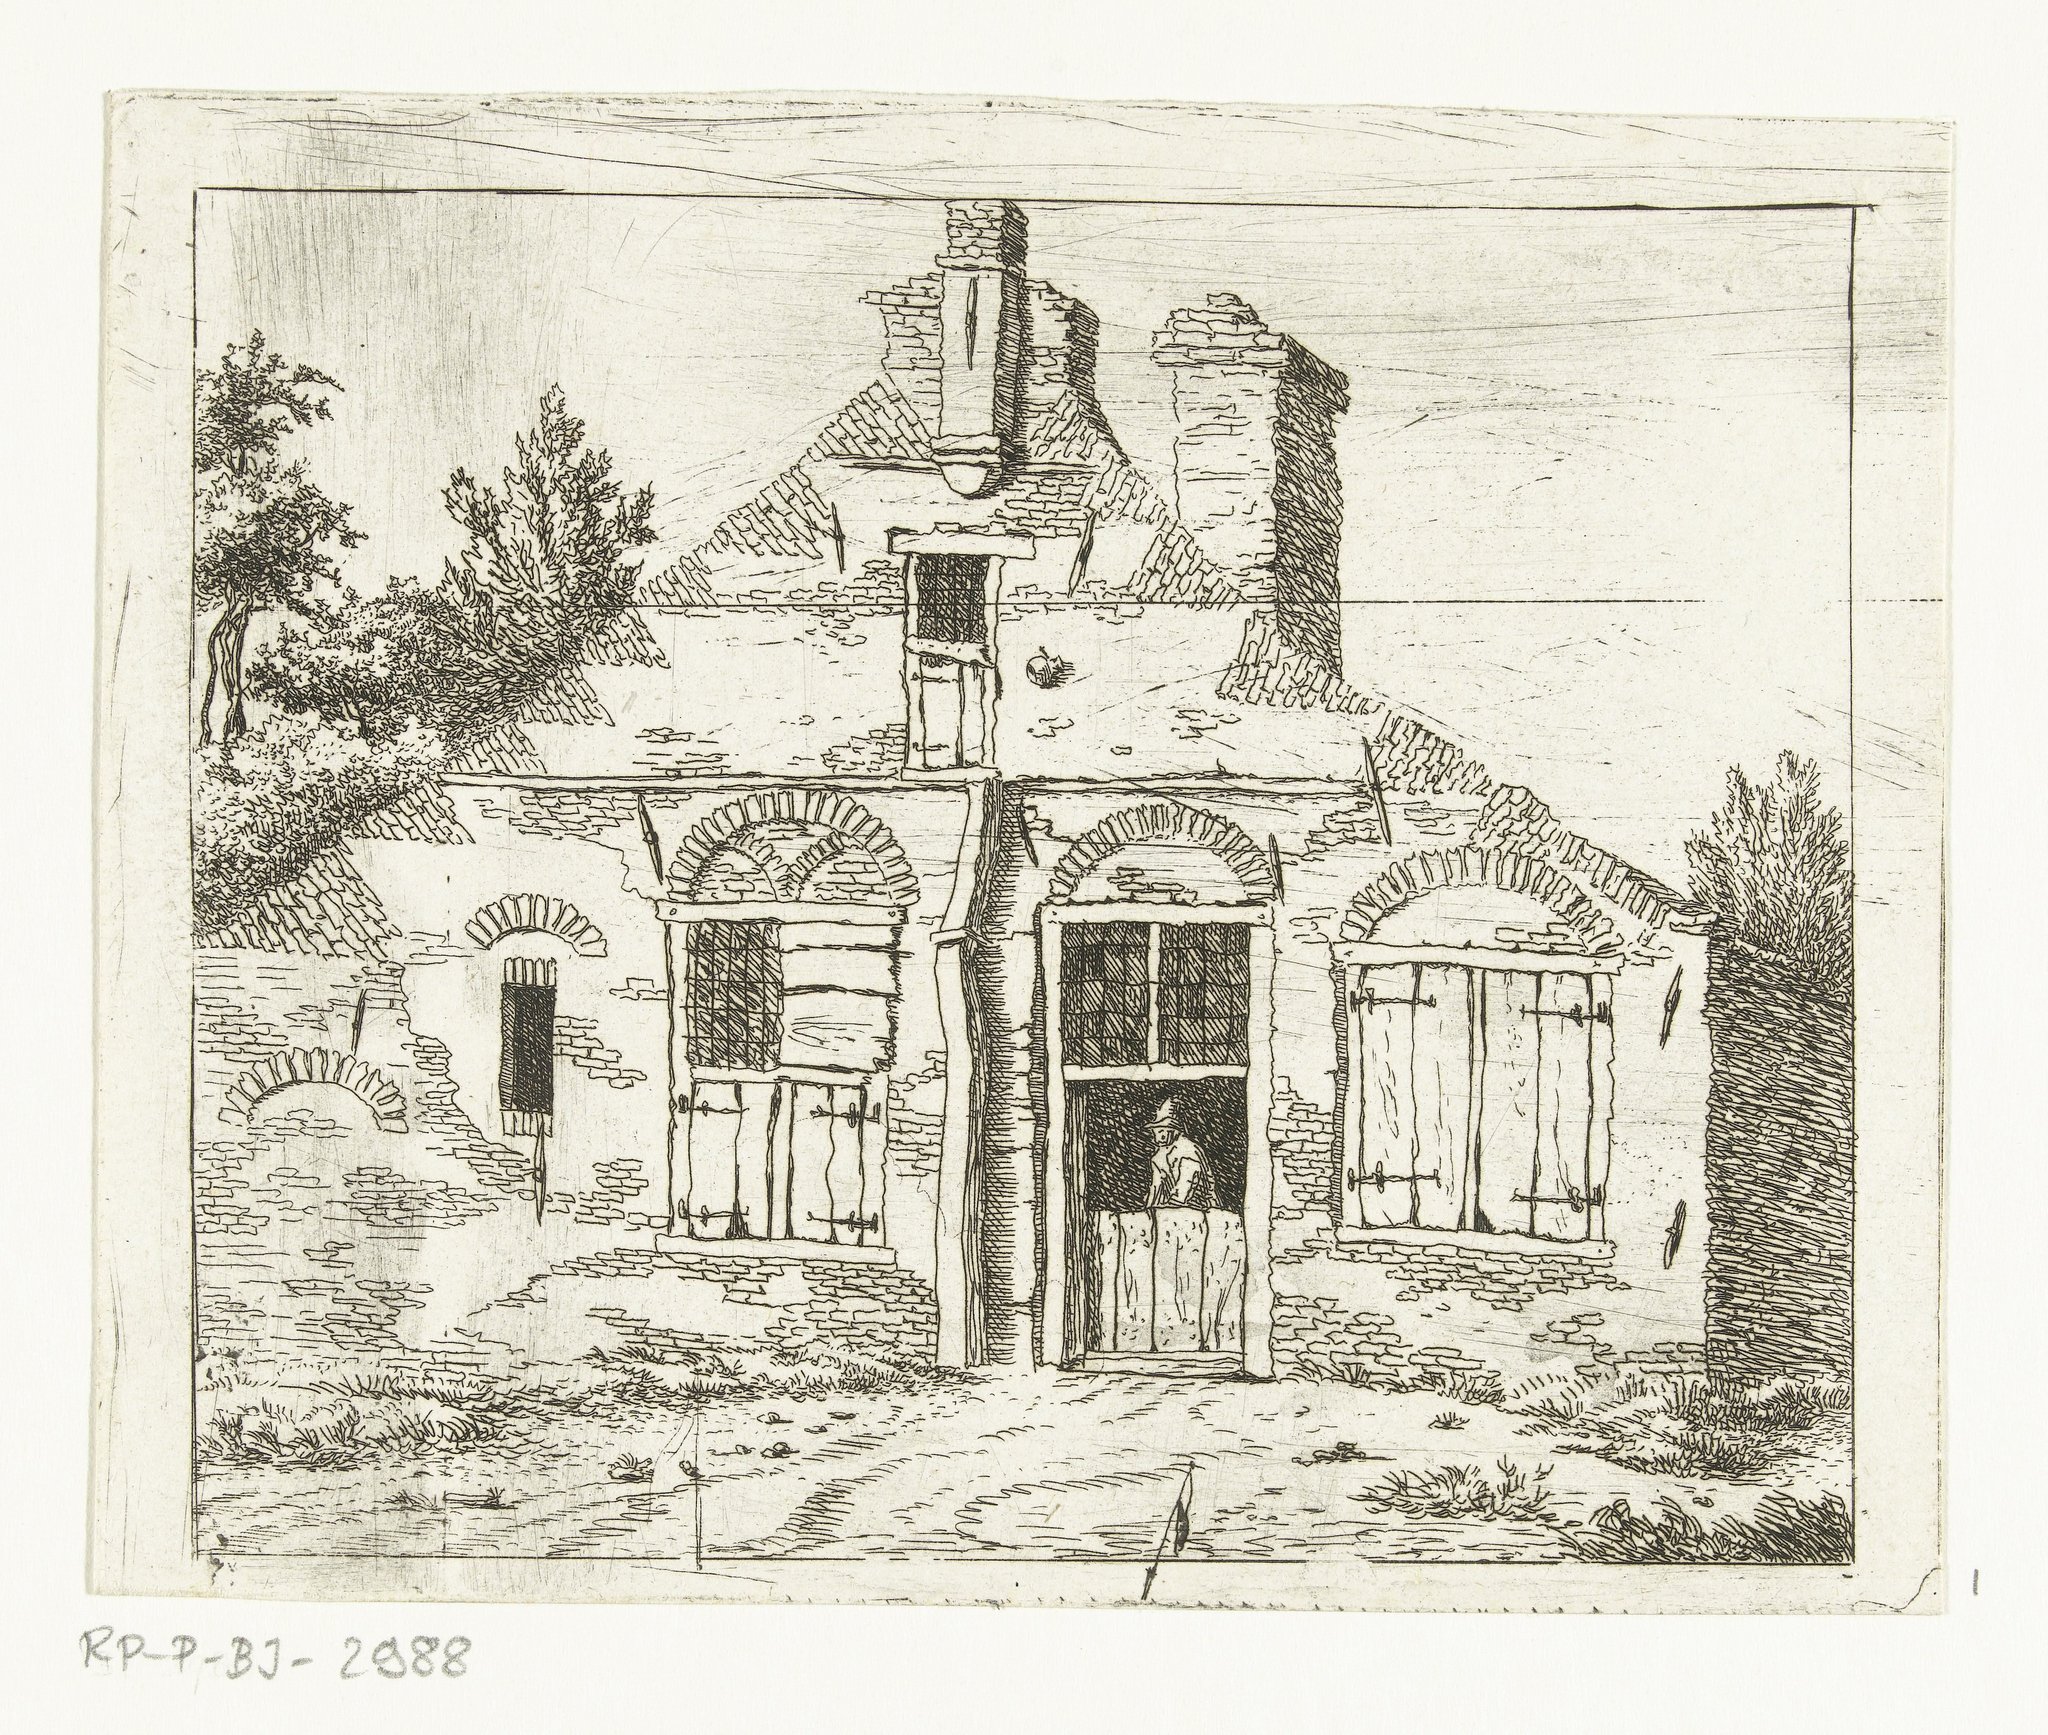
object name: print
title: Man in oud huis, naar buiten kijkend over de deur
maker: anthonie van den bos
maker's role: draughtsman, print maker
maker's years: 1763-1838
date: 1778-1838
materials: paper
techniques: etching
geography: netherlands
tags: ruin of a dwelling, house, castle, etc.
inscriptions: collector's mark: Lugt 2228